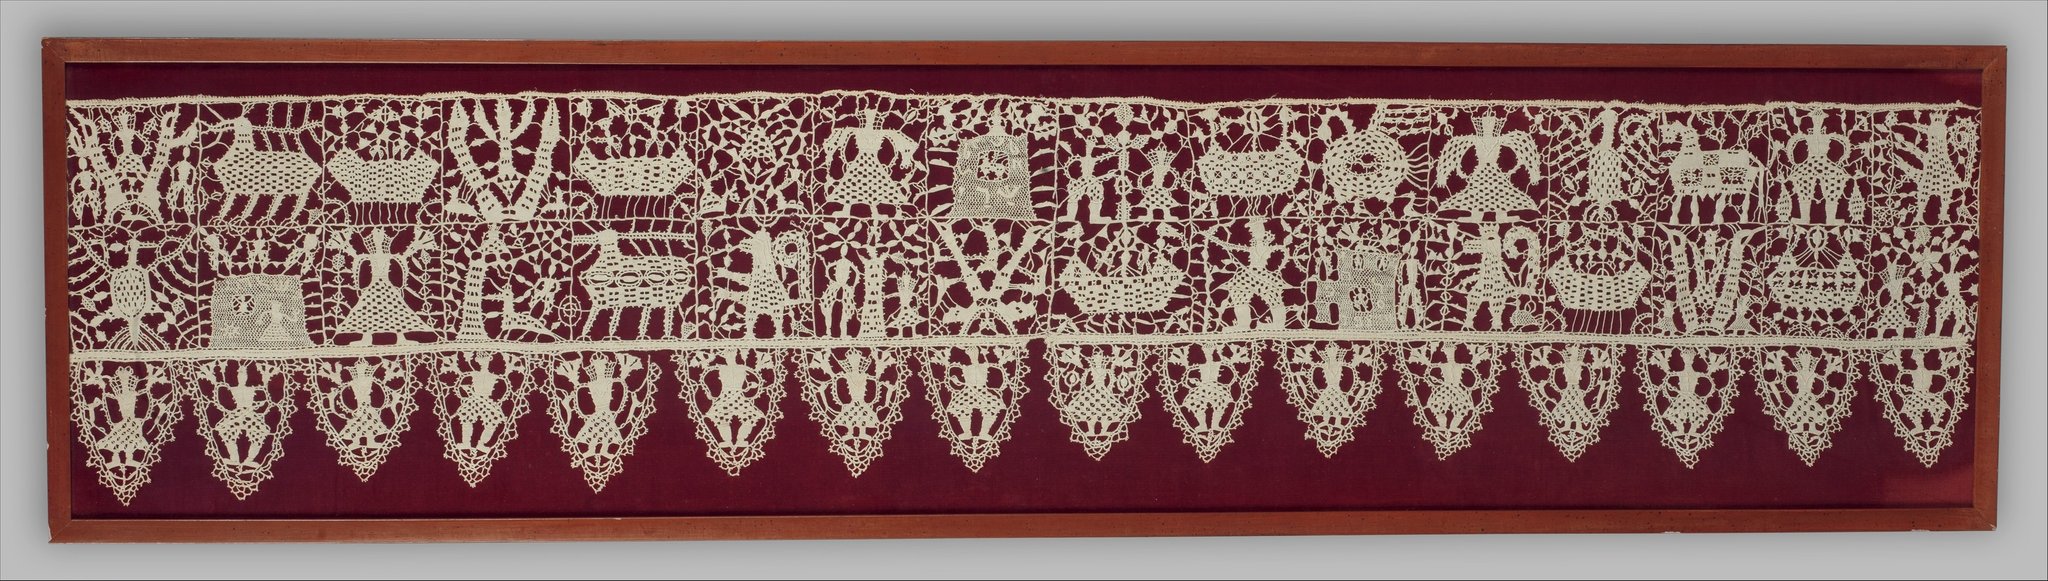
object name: border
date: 1600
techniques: lace